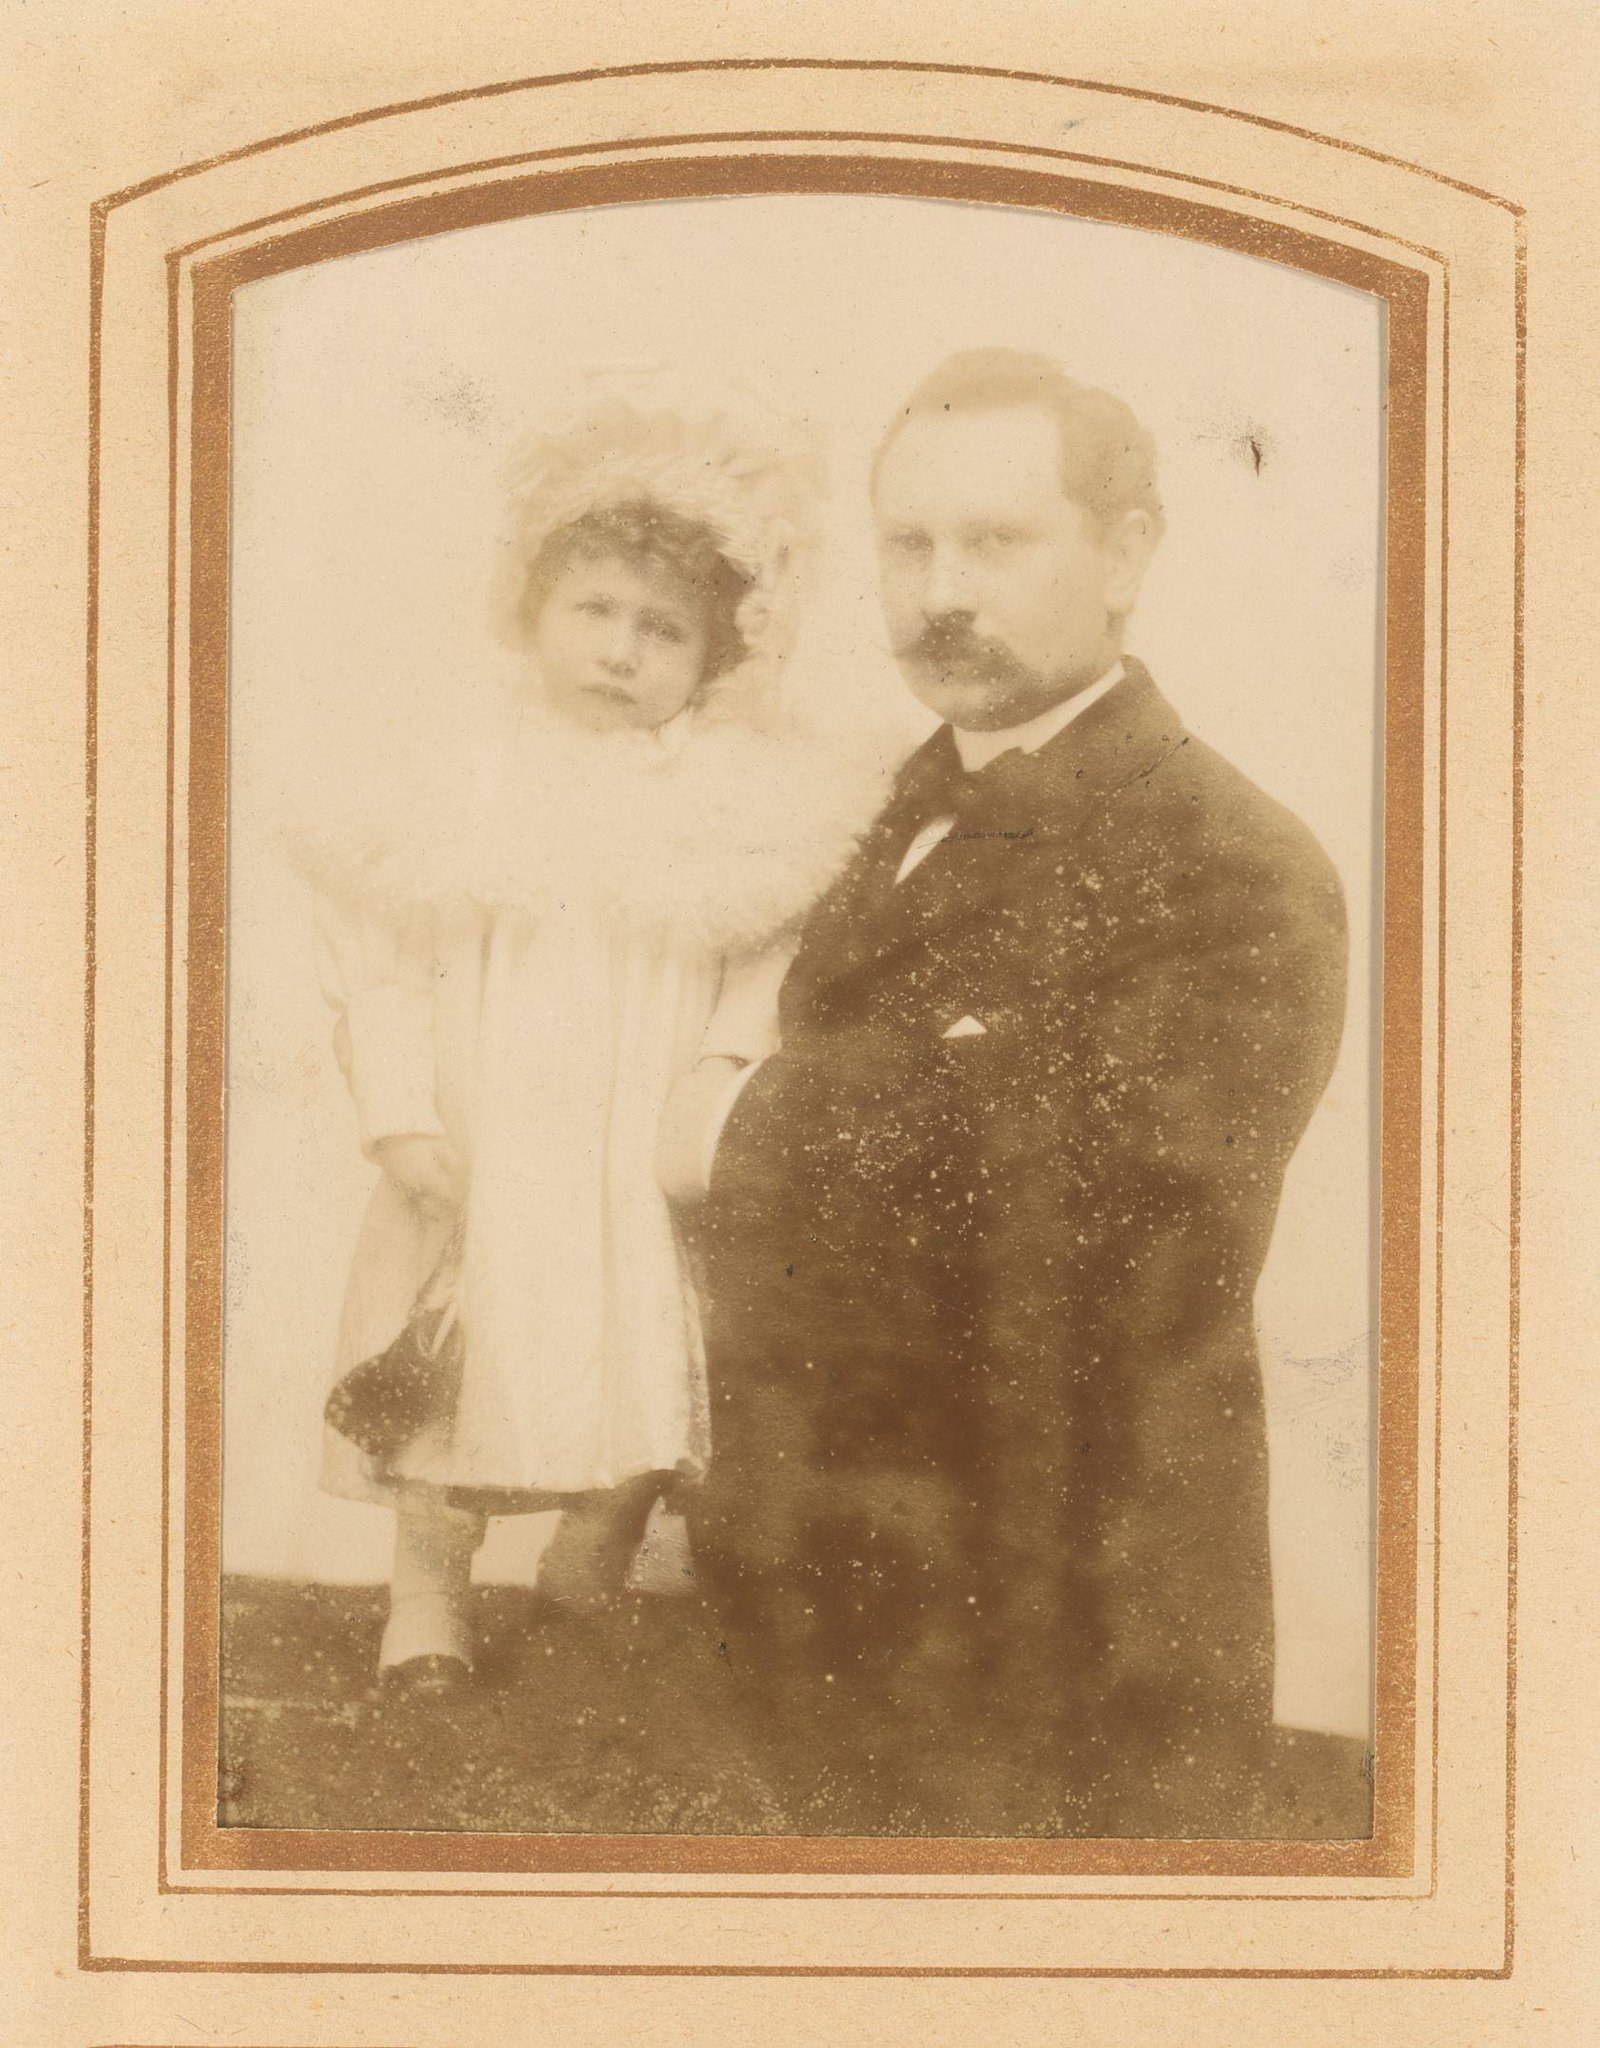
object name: cabinet photograph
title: Portret van vader en dochter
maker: Anonymous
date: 1880-1920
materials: cardboard, photographic support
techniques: gelatin silver print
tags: father and daughter(s) (family group)